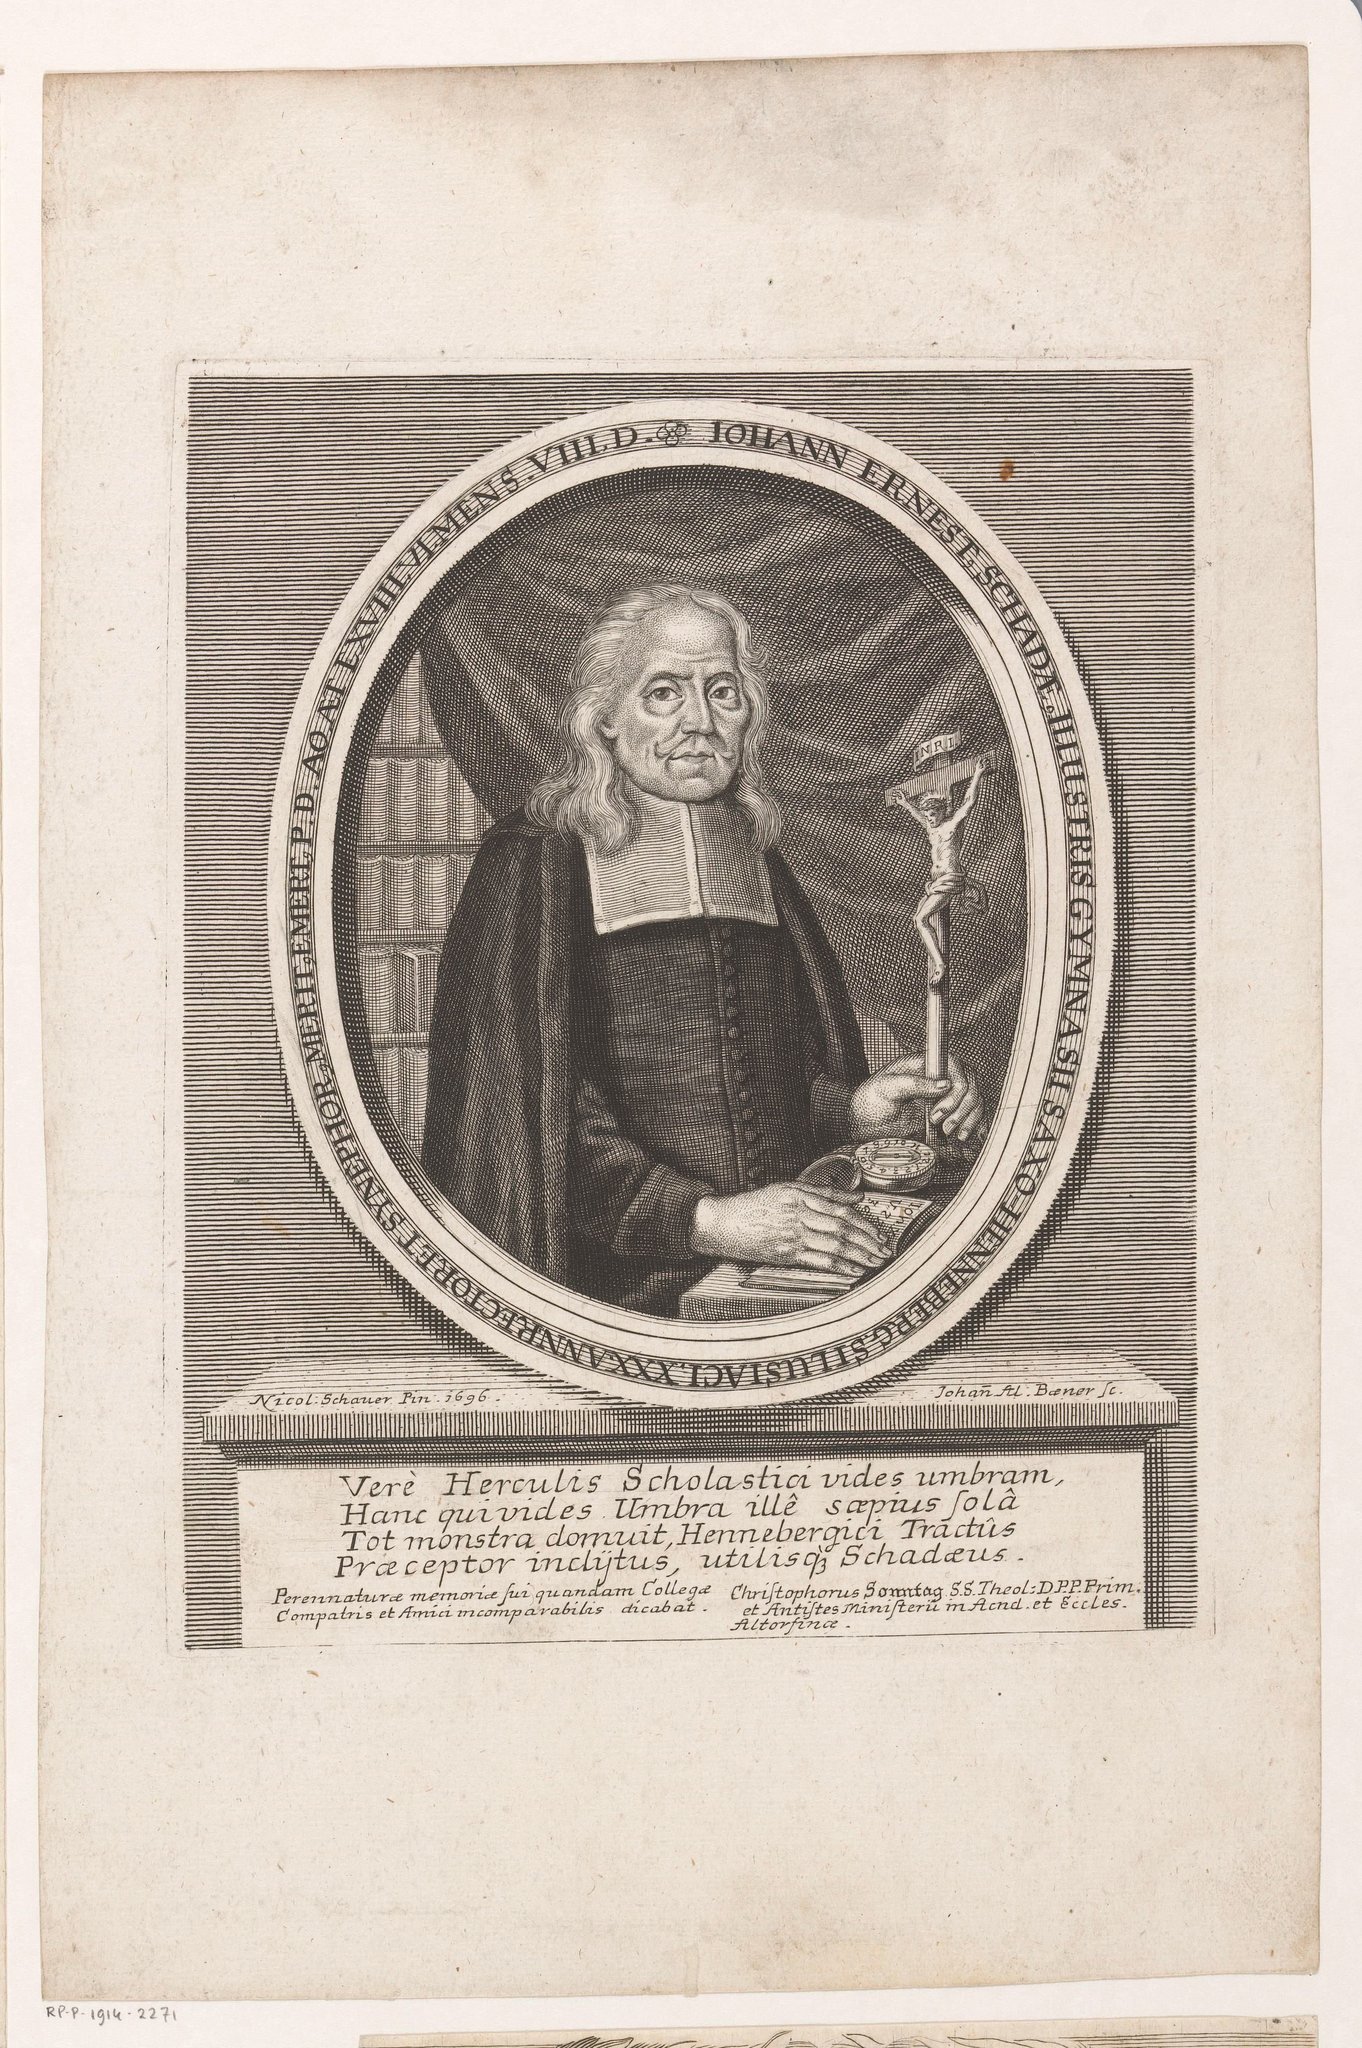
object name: print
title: Portret van Johann Ernst Schadaeus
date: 1696-1720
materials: paper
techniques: engraving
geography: nuremberg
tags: johann ernst schadaeus, bookshelves, historical persons, book - mm - book open, crucifix ~ personal devotion, watch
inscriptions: collector's mark: Lugt 2228